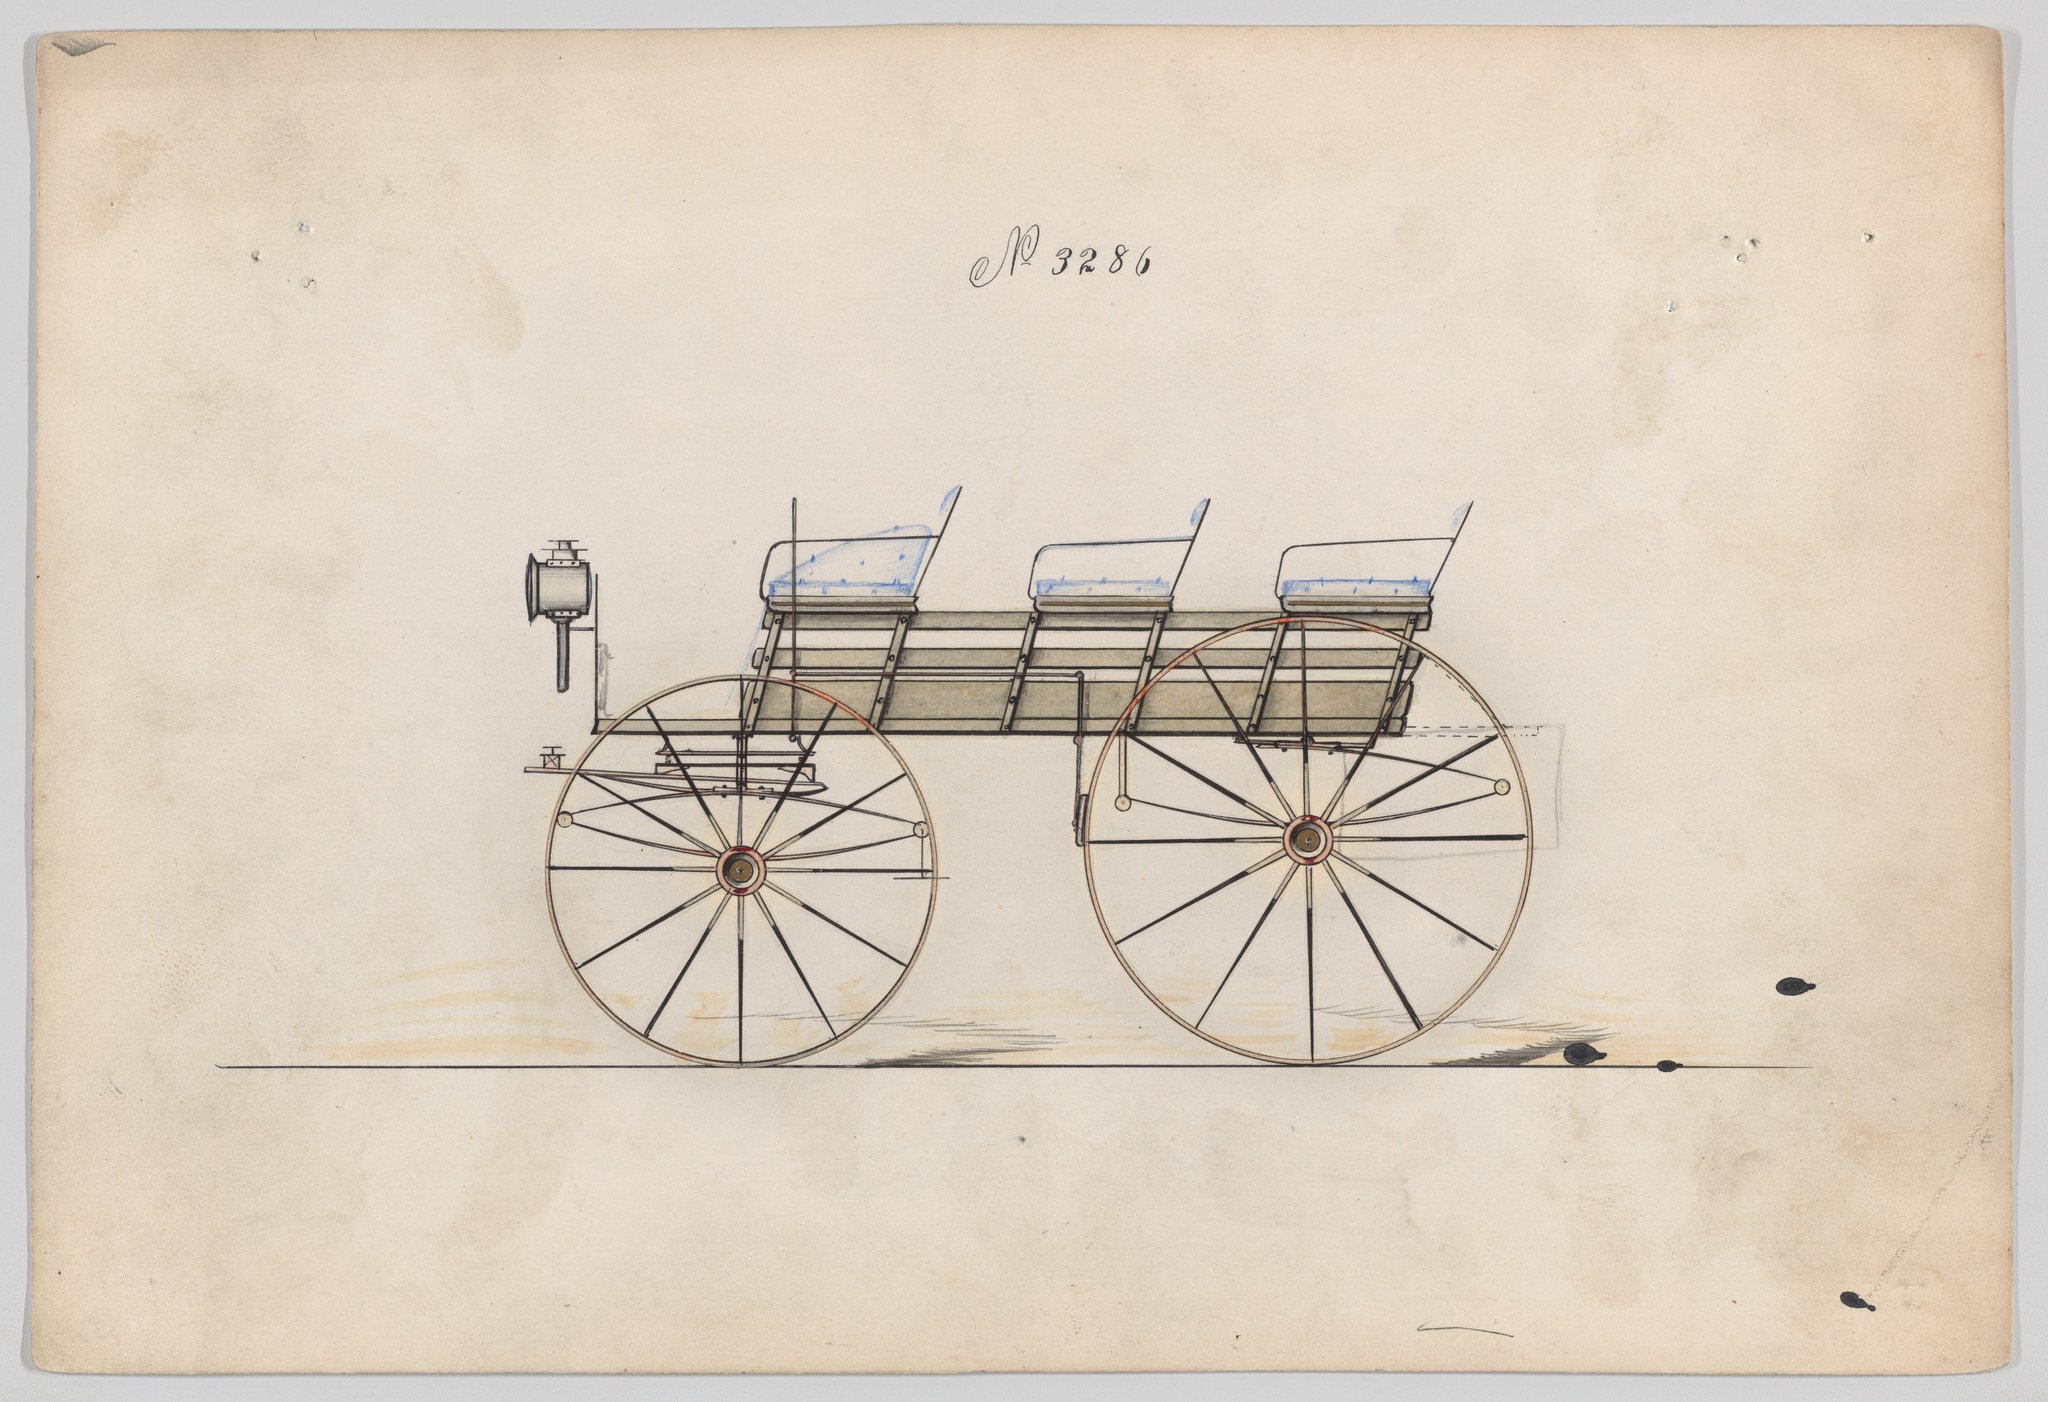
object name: drawing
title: Slat Side Phaeton #3286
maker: brewster & co.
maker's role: manufacturer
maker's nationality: american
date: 1876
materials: graphite, gum arabic, ink, watercolor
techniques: pen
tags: carriages